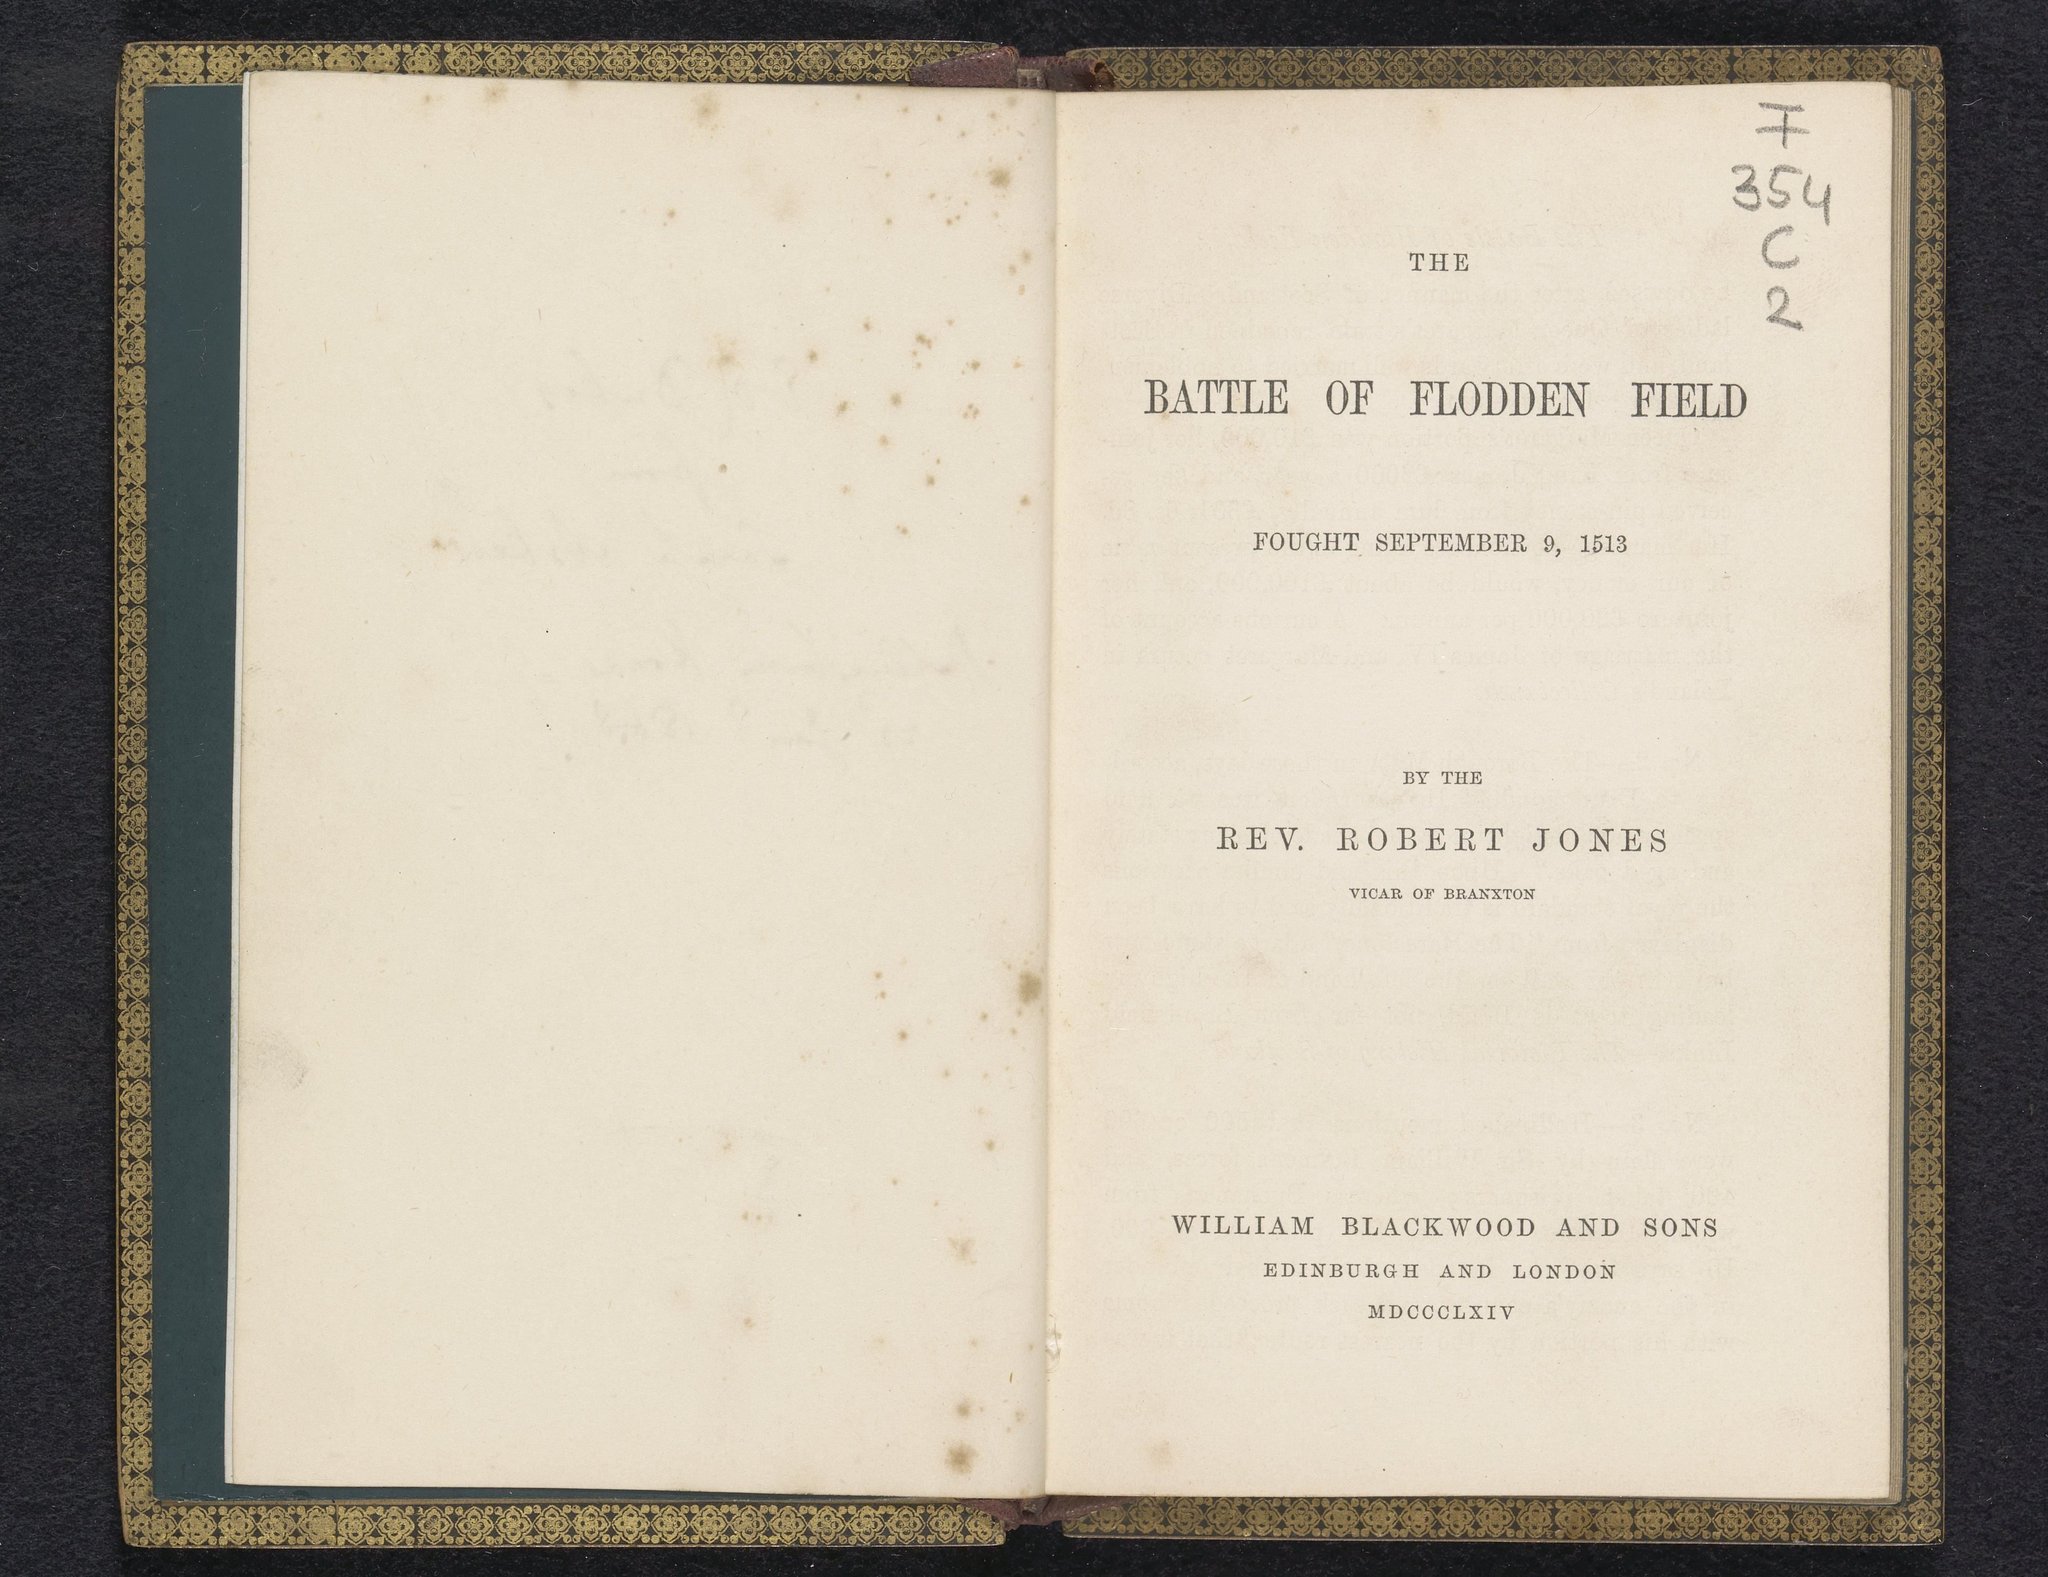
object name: book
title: The battle of flodden field fought September 9, 1513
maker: robert jones (dominee)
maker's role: dominee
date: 1864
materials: paper, wood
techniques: photograph, printing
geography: edinburgh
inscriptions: inscription: ‘Ed Dukes from Sarah Askew [...]burn House 22 Jan 1868.’